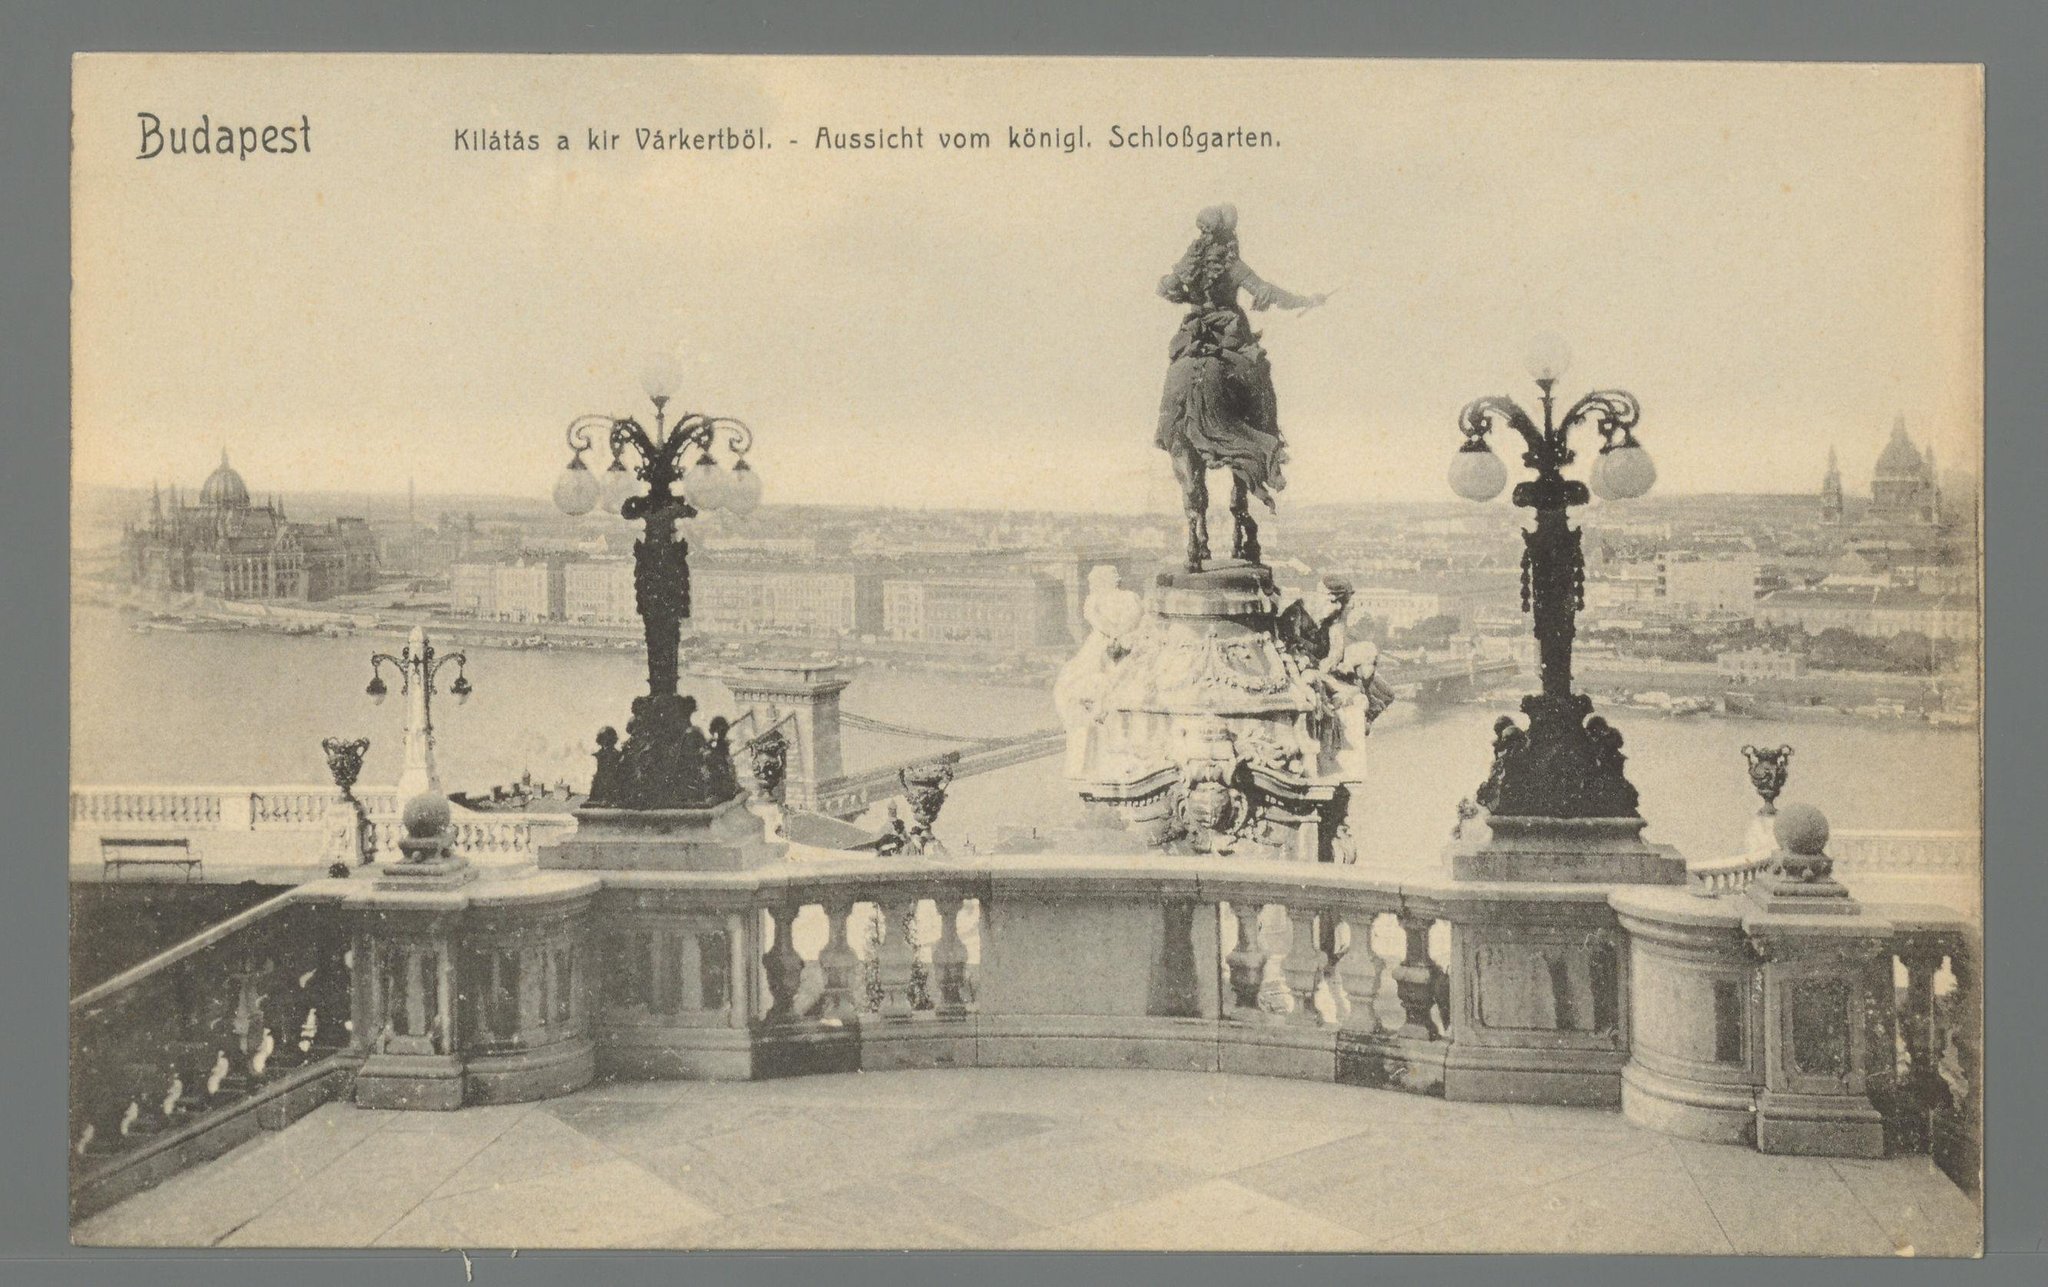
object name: ansichtkaart, prentbriefkaart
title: Budapest. Kilátás a kir Várkertböl / Aussicht vom königl. Schloβgarten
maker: Anonymous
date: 1905-1930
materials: cardboard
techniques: photograph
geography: budapest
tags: castle, monument, statue, canals, waters (in city), bridge in city across river, canal, etc.